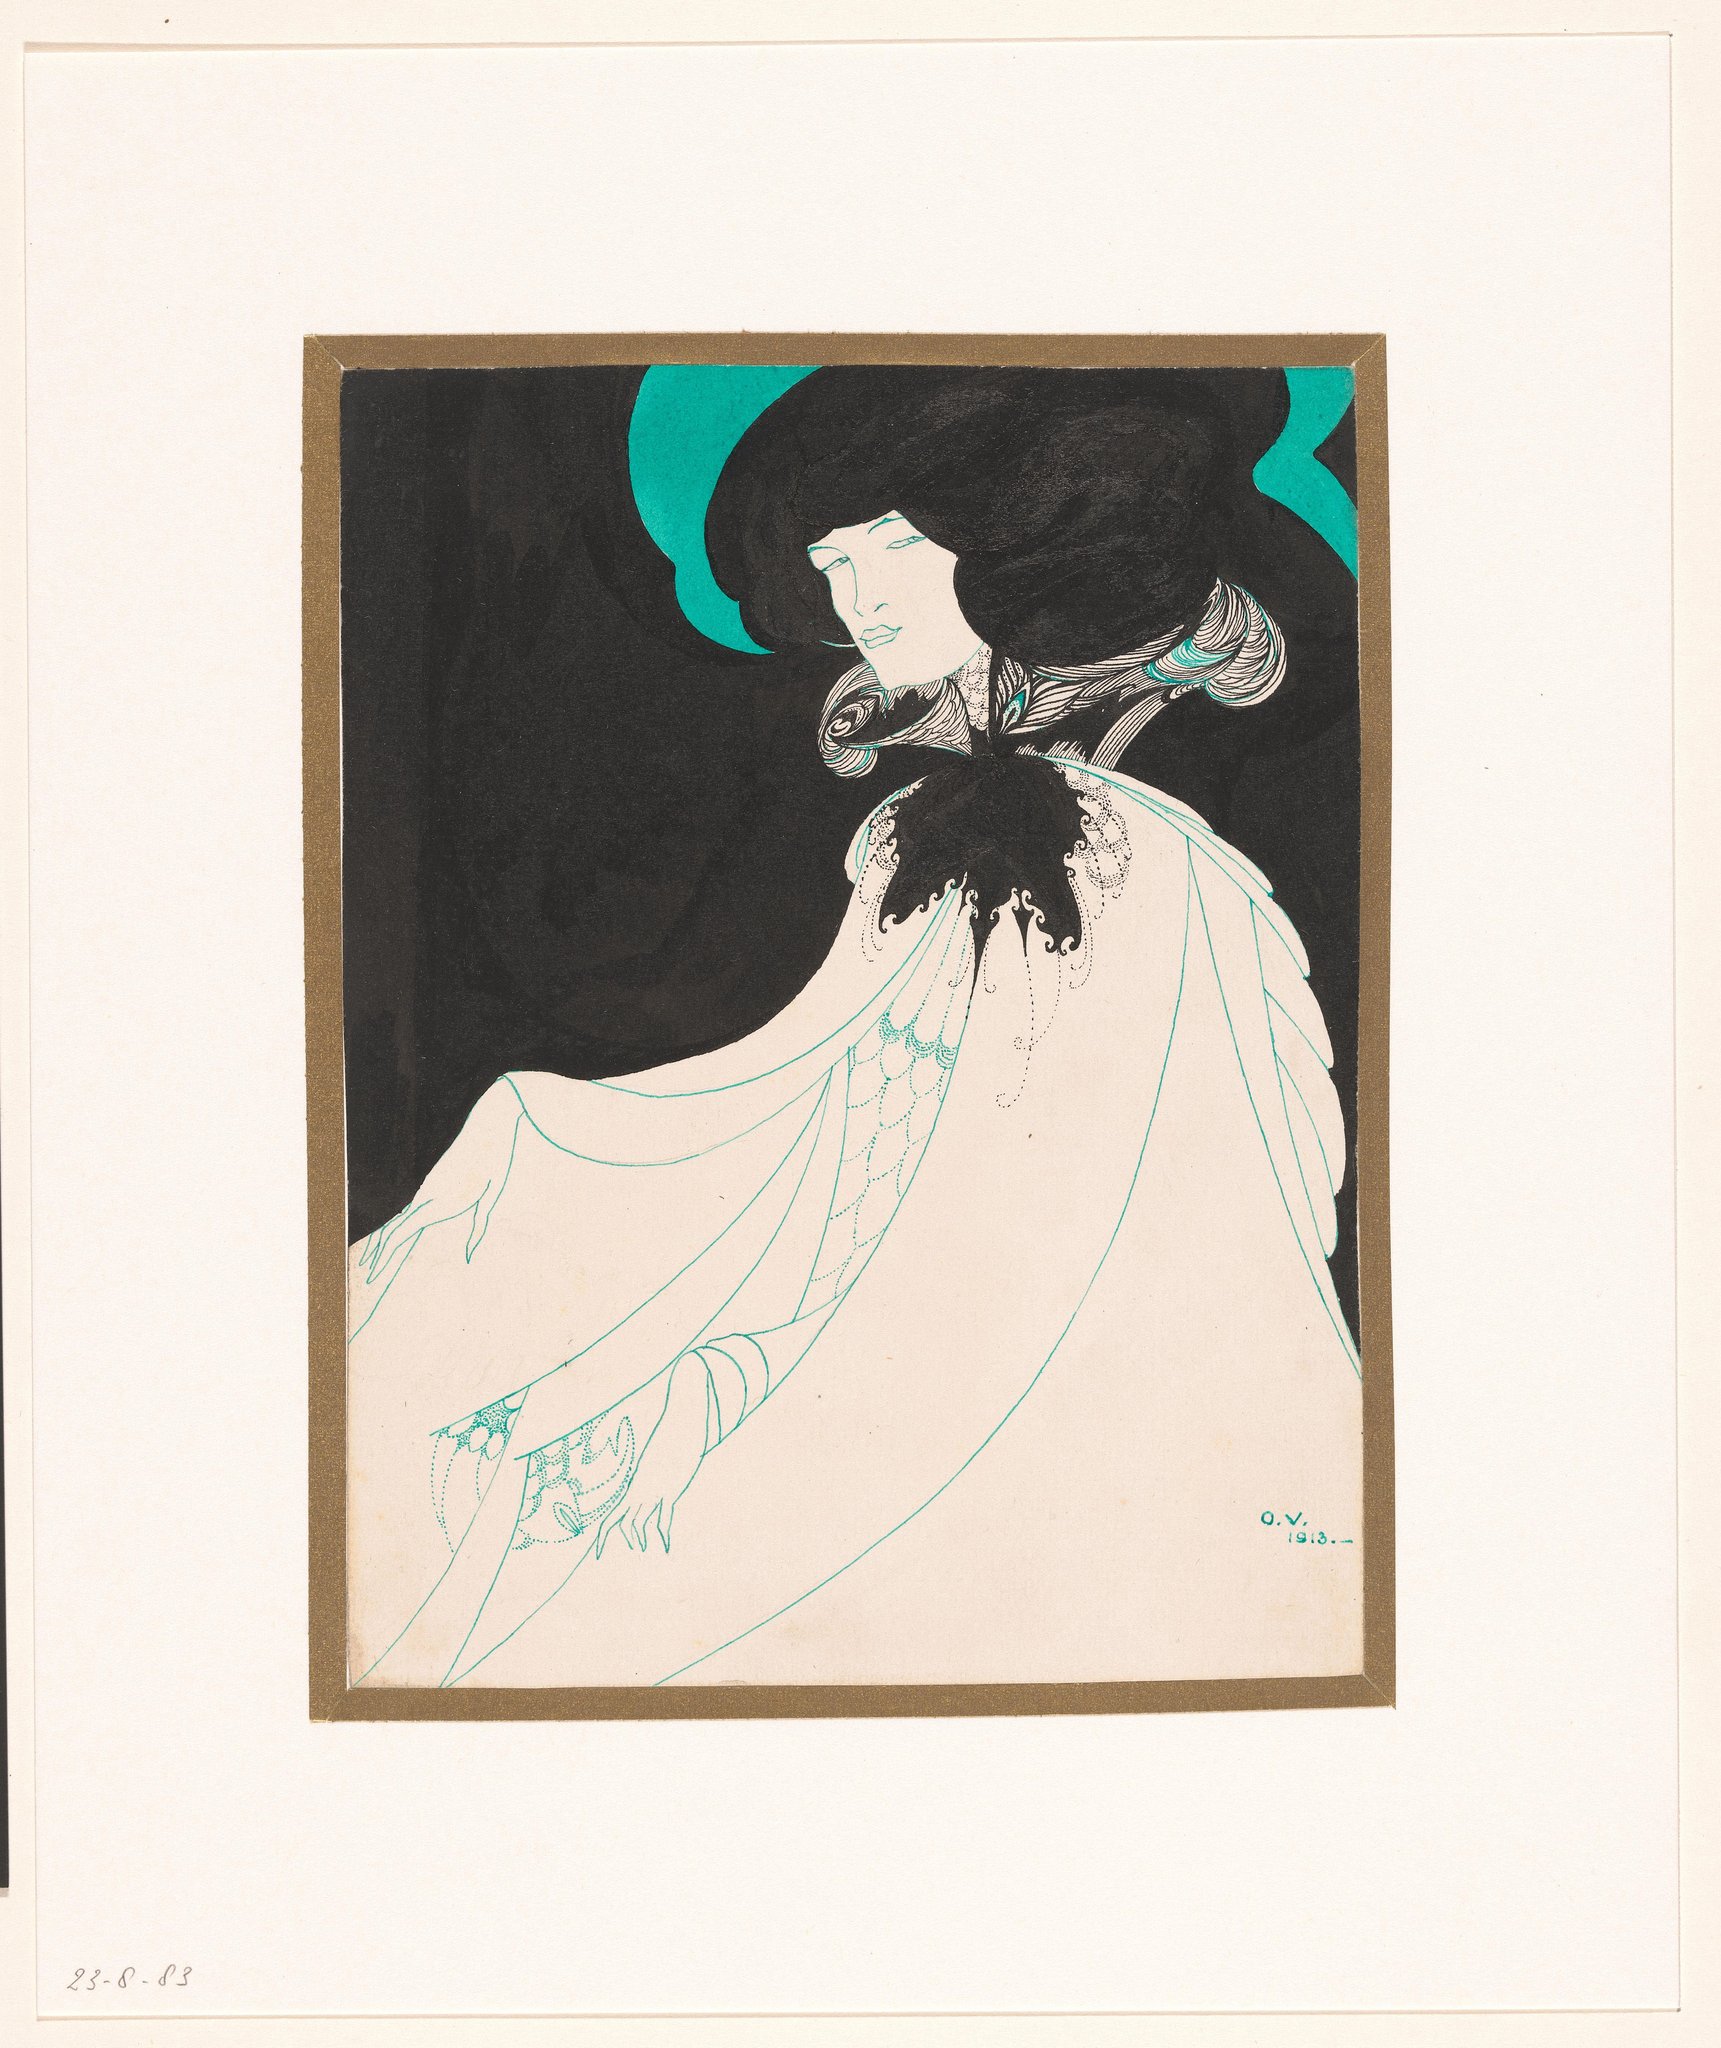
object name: drawing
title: Zittende vrouw met een mantel aan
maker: otto verhagen (i)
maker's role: draughtsman, print maker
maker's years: 1885-1951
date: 1913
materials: ink, paper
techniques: brush, pen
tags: adult woman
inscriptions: collector's mark: Lugt 2228